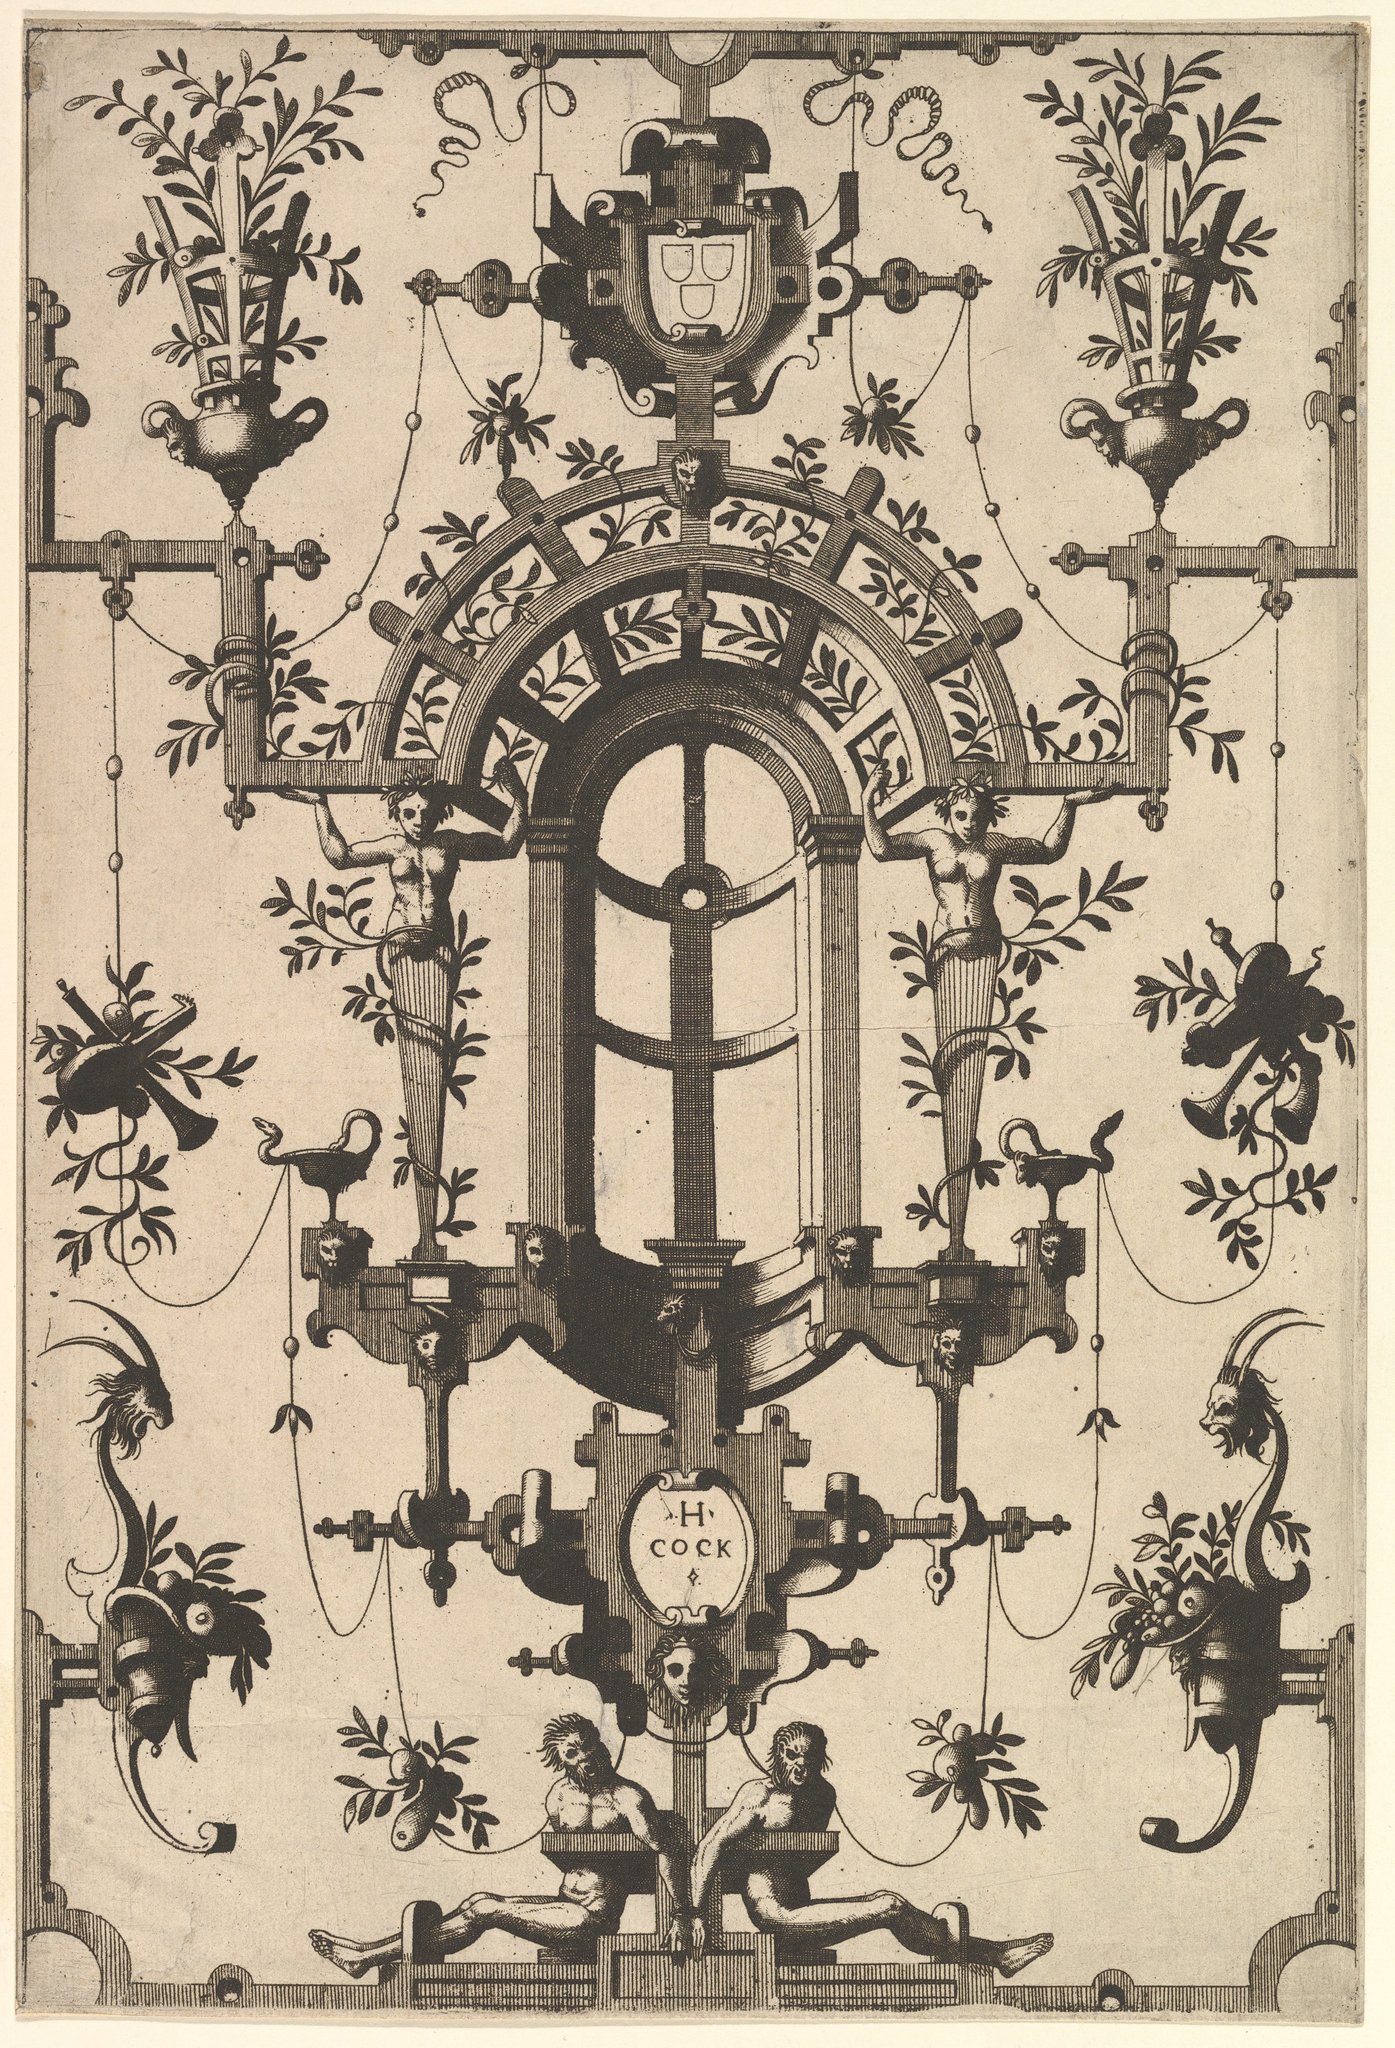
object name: print collection ornament architecture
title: Modern Grotesque with Strapwork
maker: johannes van doetecum i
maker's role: artist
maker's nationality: netherlandish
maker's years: 1528-1605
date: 1554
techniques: etching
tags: grotesques,ornament